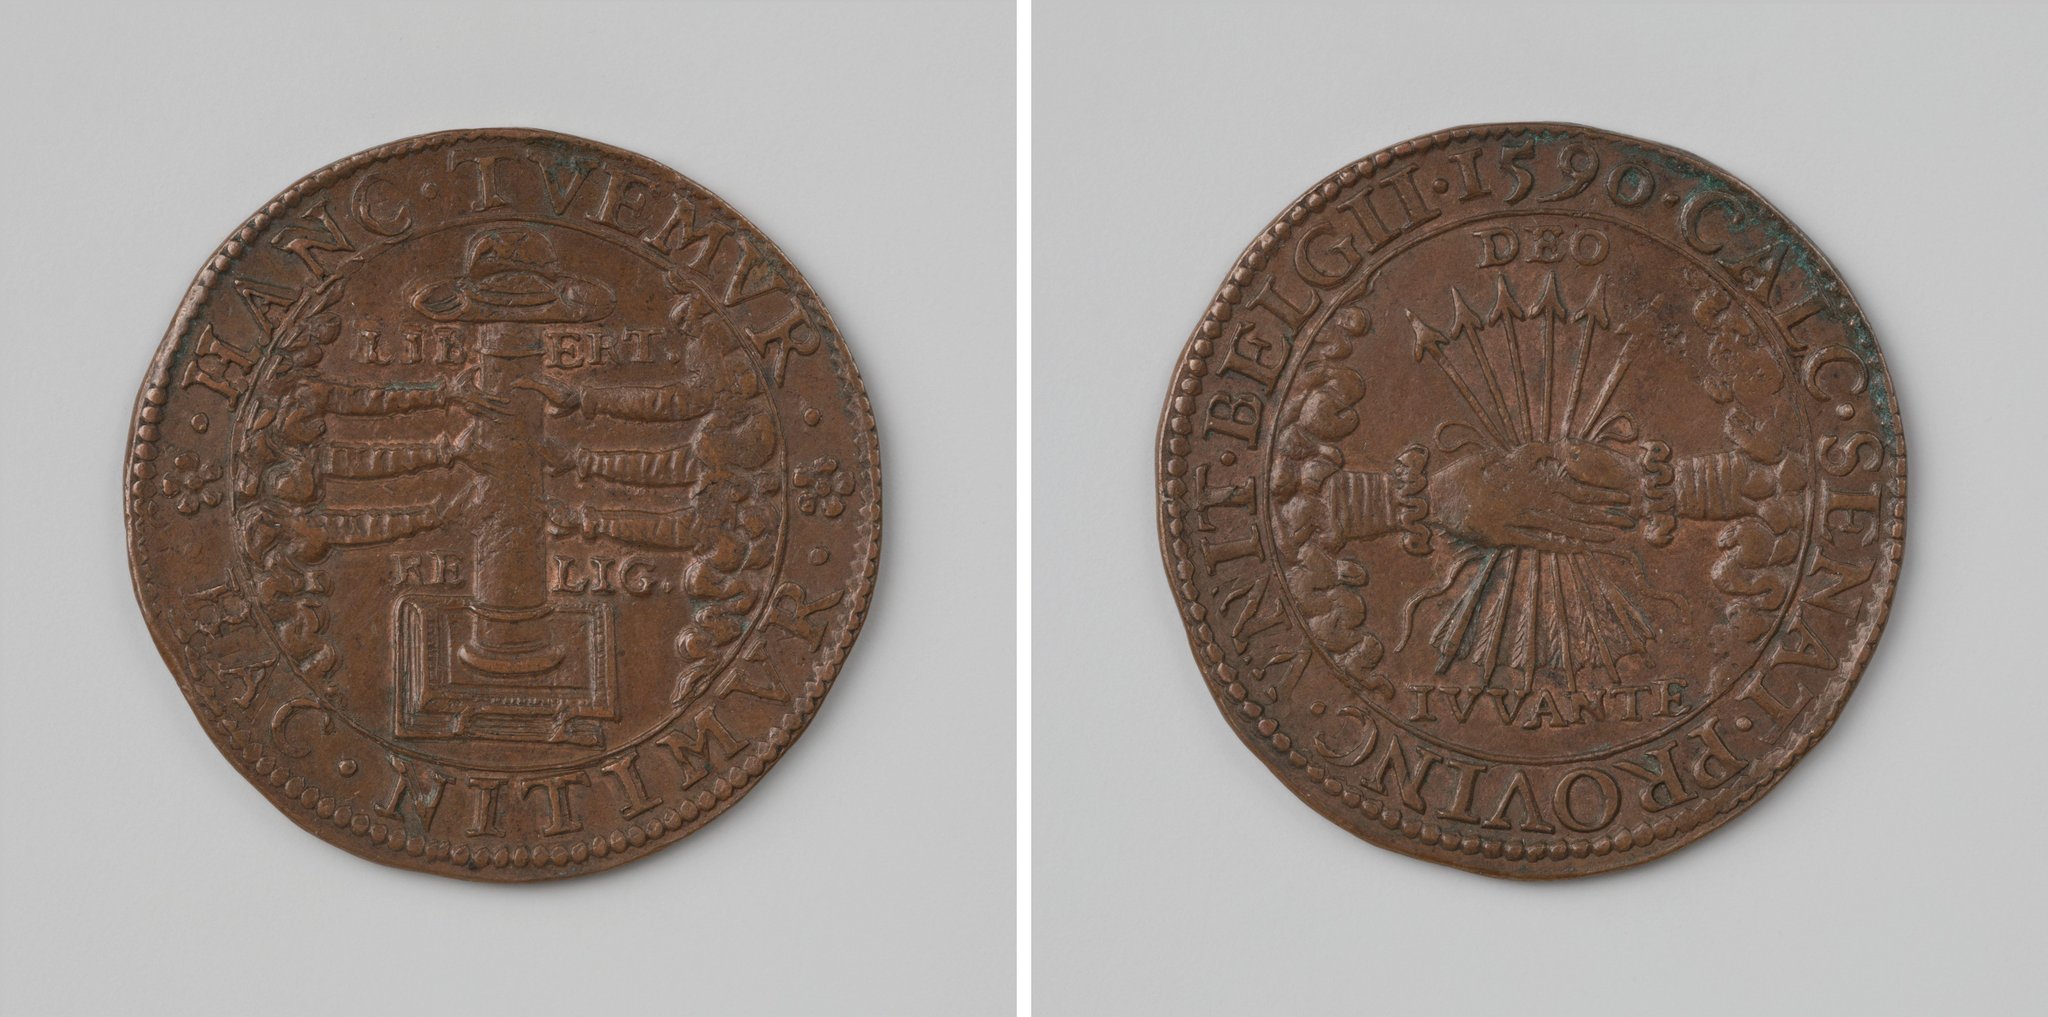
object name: jeton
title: Verkiezing van Maurits, graaf van Nassau gekozen tot stadhouder van alle opstandige gewesten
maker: Anonymous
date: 1590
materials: copper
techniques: striking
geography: dordrecht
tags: the hague, maurice (prince of orange)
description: Koperen penning. Voorzijde: zes handen uit wolken houden gezamelijk een zuil vast, die op een bijbel rust en door een vrijheidshoed bekroond wordt; onder vrijheidshoed en boven bijbel: opschriften binnen omschrift. Keerzijde: twee ineen geslagen handen houden samen bundel van zes pijlen vast tussen opschriften binnen omschrift